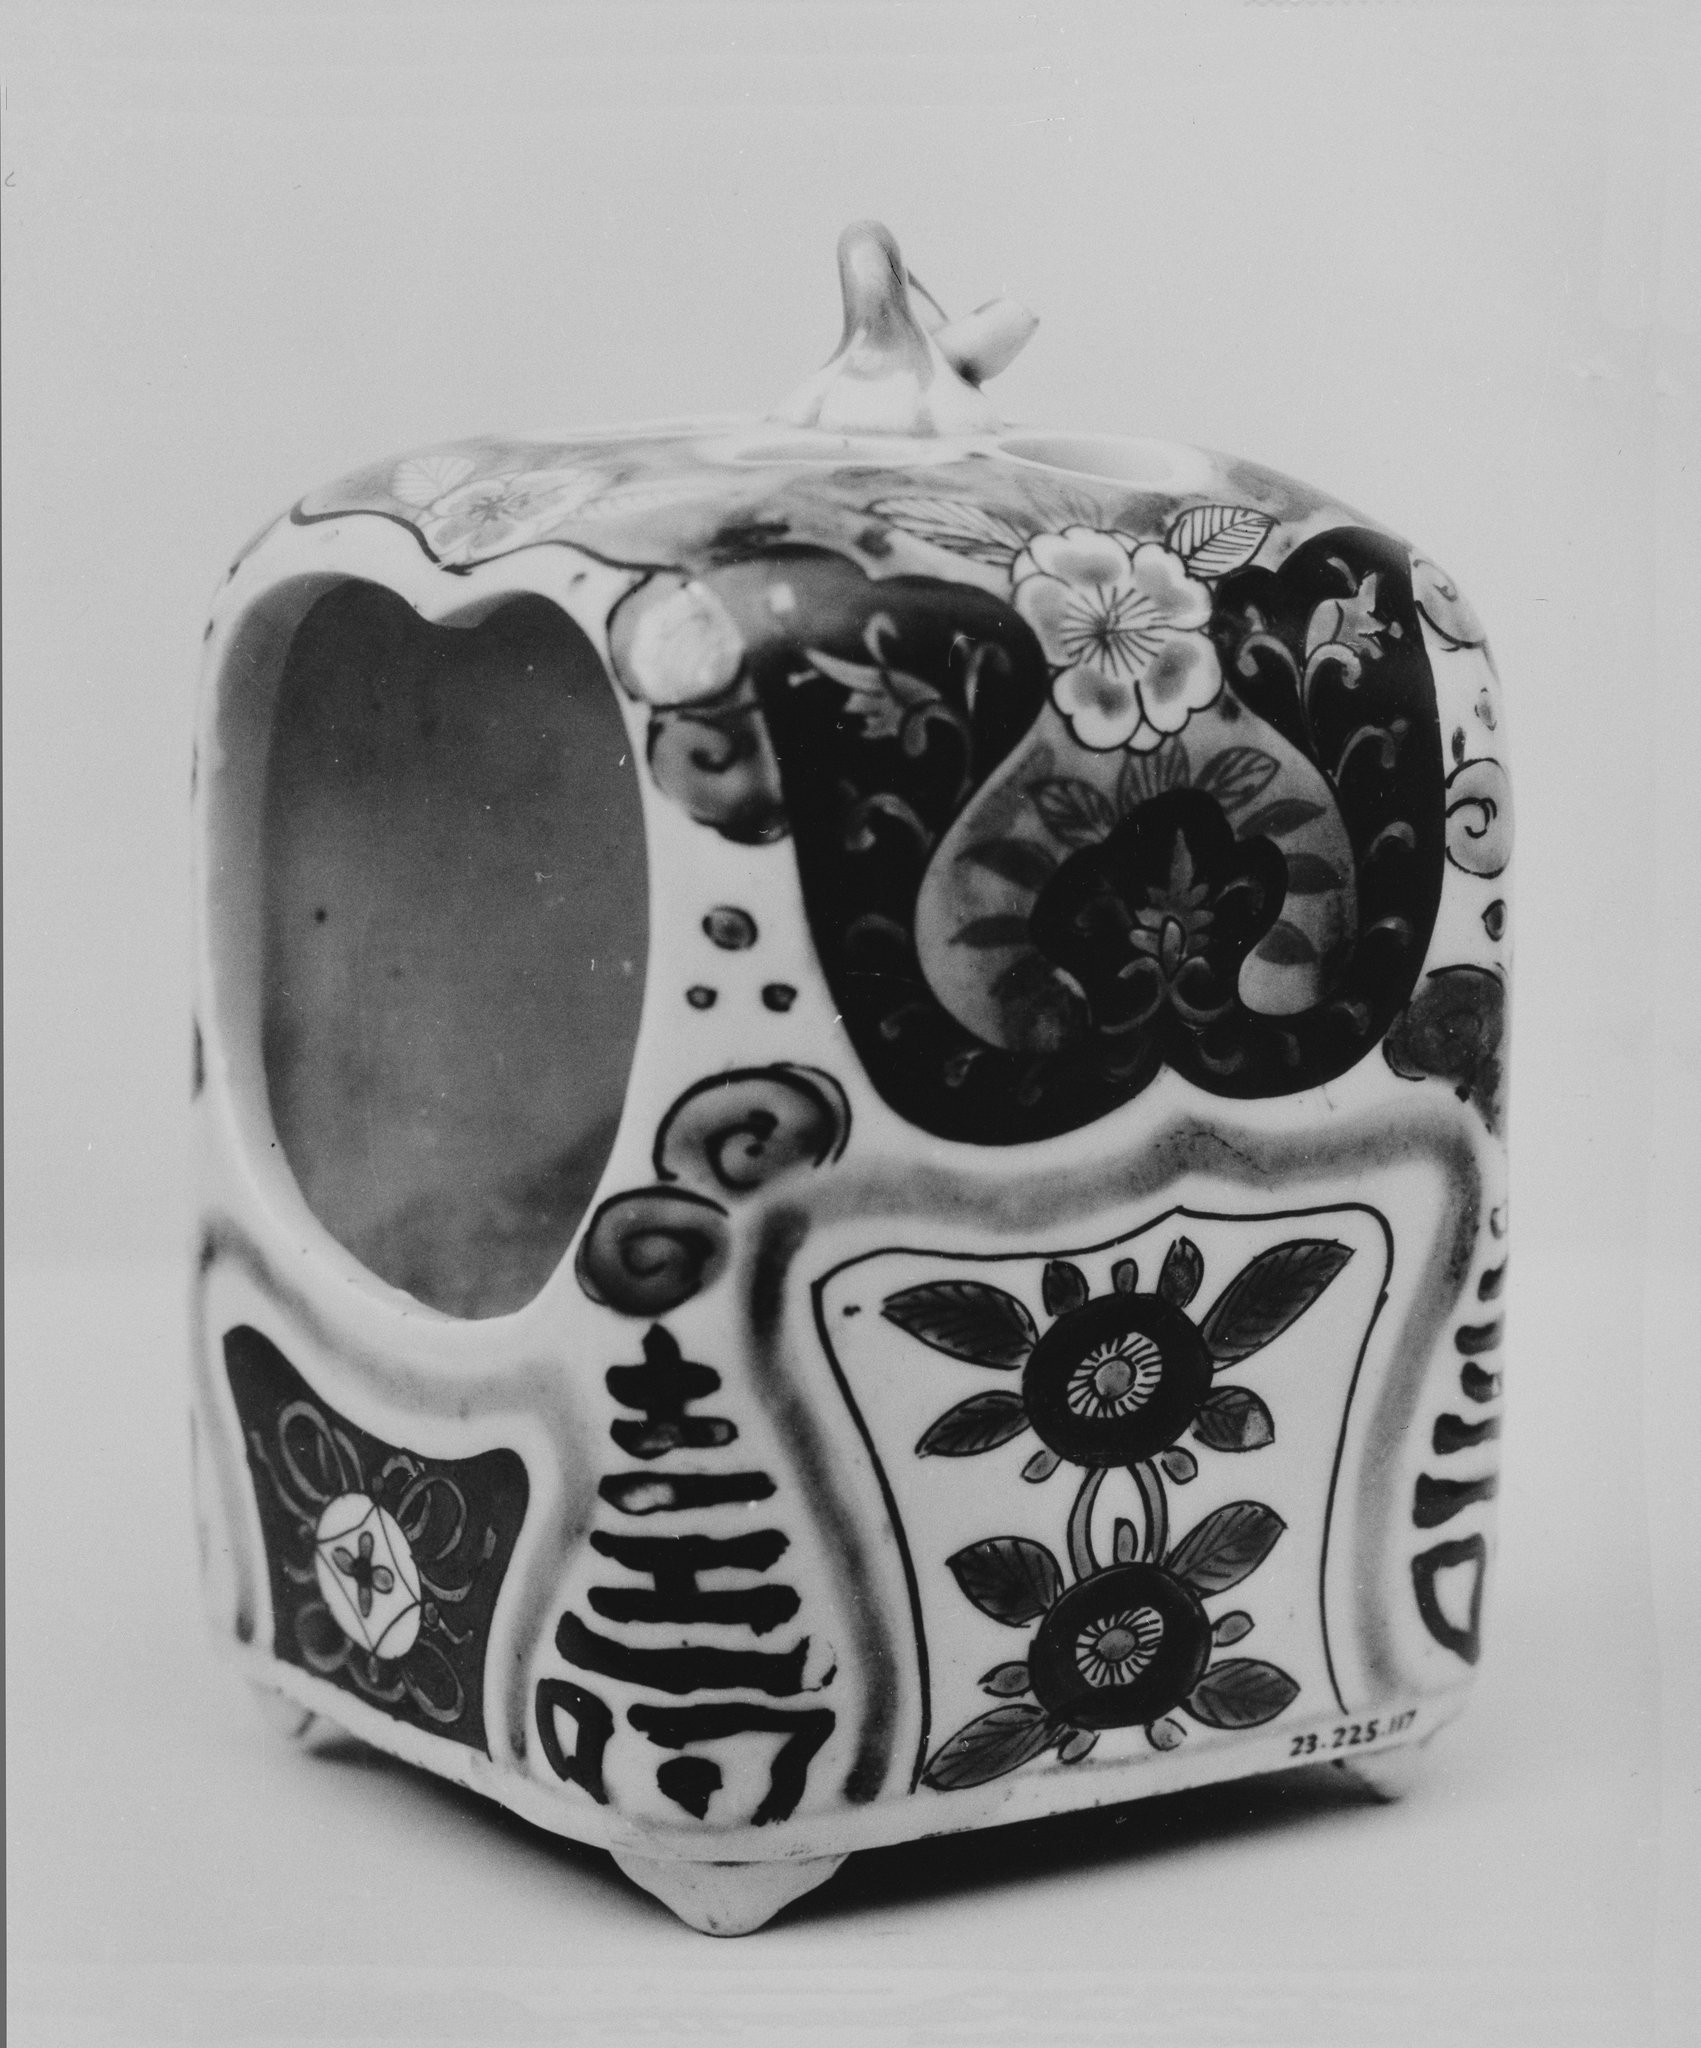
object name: censer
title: Censer with Ideograph "Ju"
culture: japanese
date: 1700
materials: enamel, porcelain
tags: flowers,censers